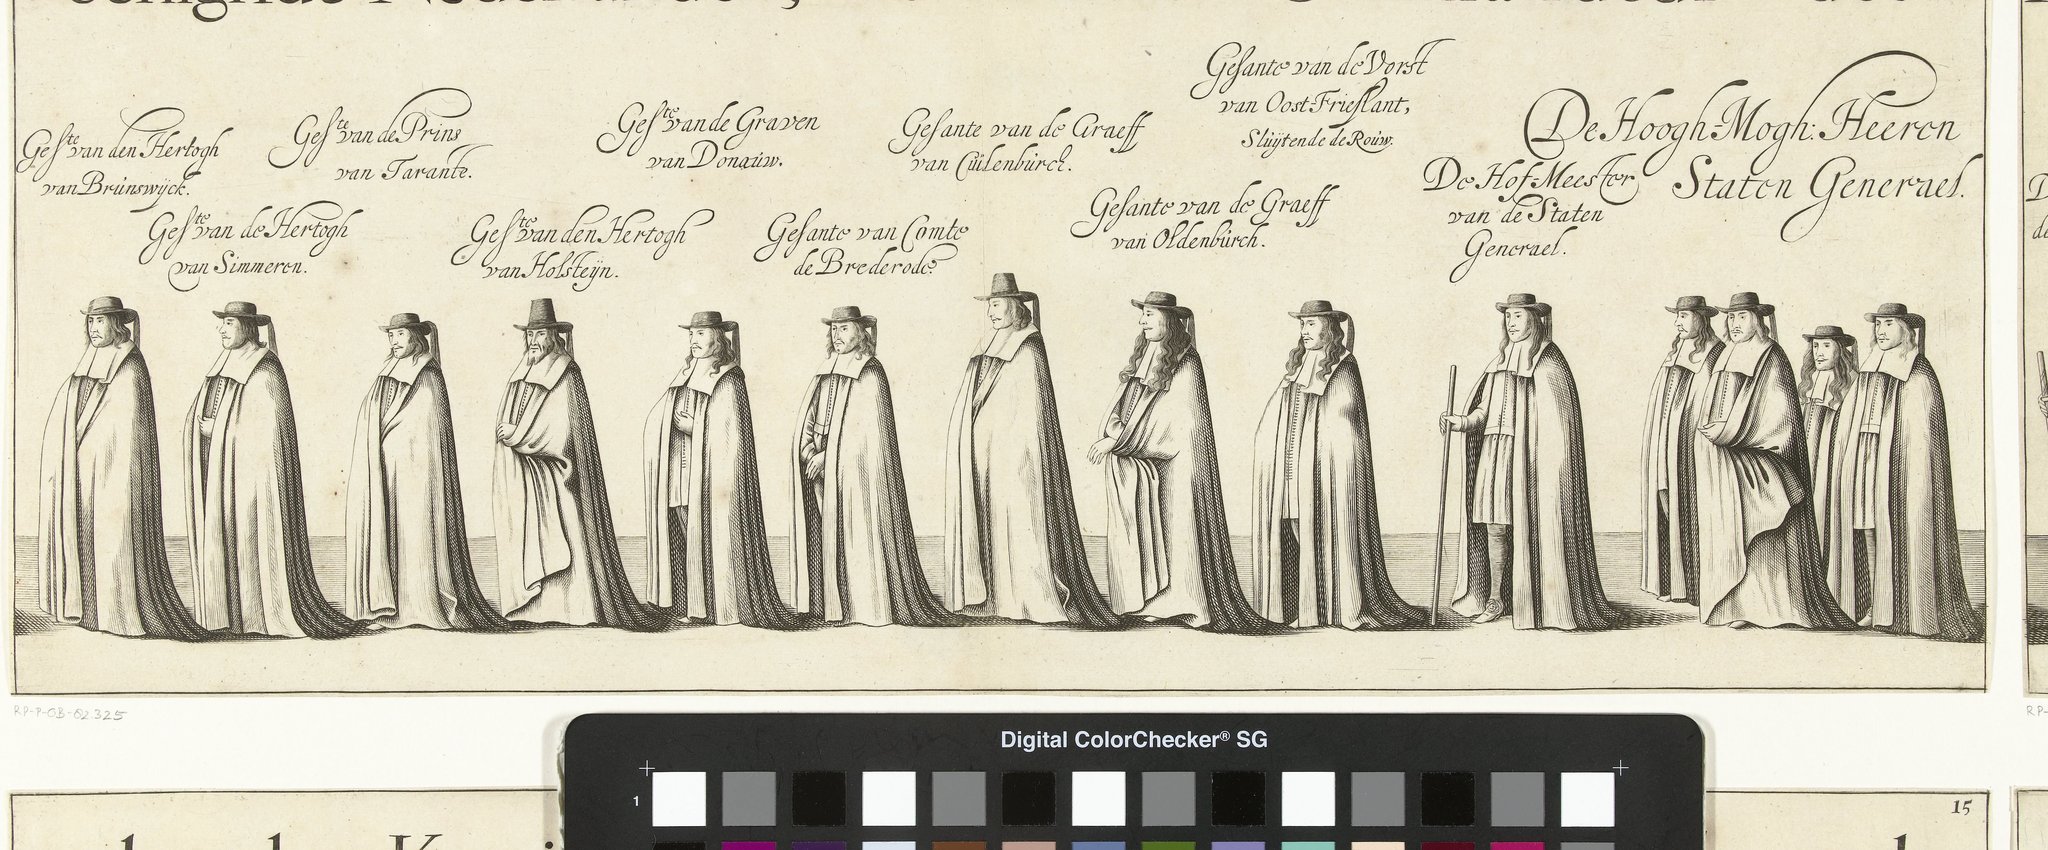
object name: print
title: Begrafenisoptocht van Willem Frederik, graaf van Nassau-Dietz (blad 13), 1665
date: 1666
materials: paper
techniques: engraving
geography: leeuwarden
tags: arnhem, cortege, funeral procession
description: Begrafenisoptocht van Willem Frederik, graaf van Nassau-Dietz, in Leeuwarden op 6 januari 1665. Deel van de begrafenisstoet. Plaat nr. 13 in een ensemble van 24 (van de 25) ongemonteerde genummerde platen (zonder tekstbladen) die samen een lange fries vormen.